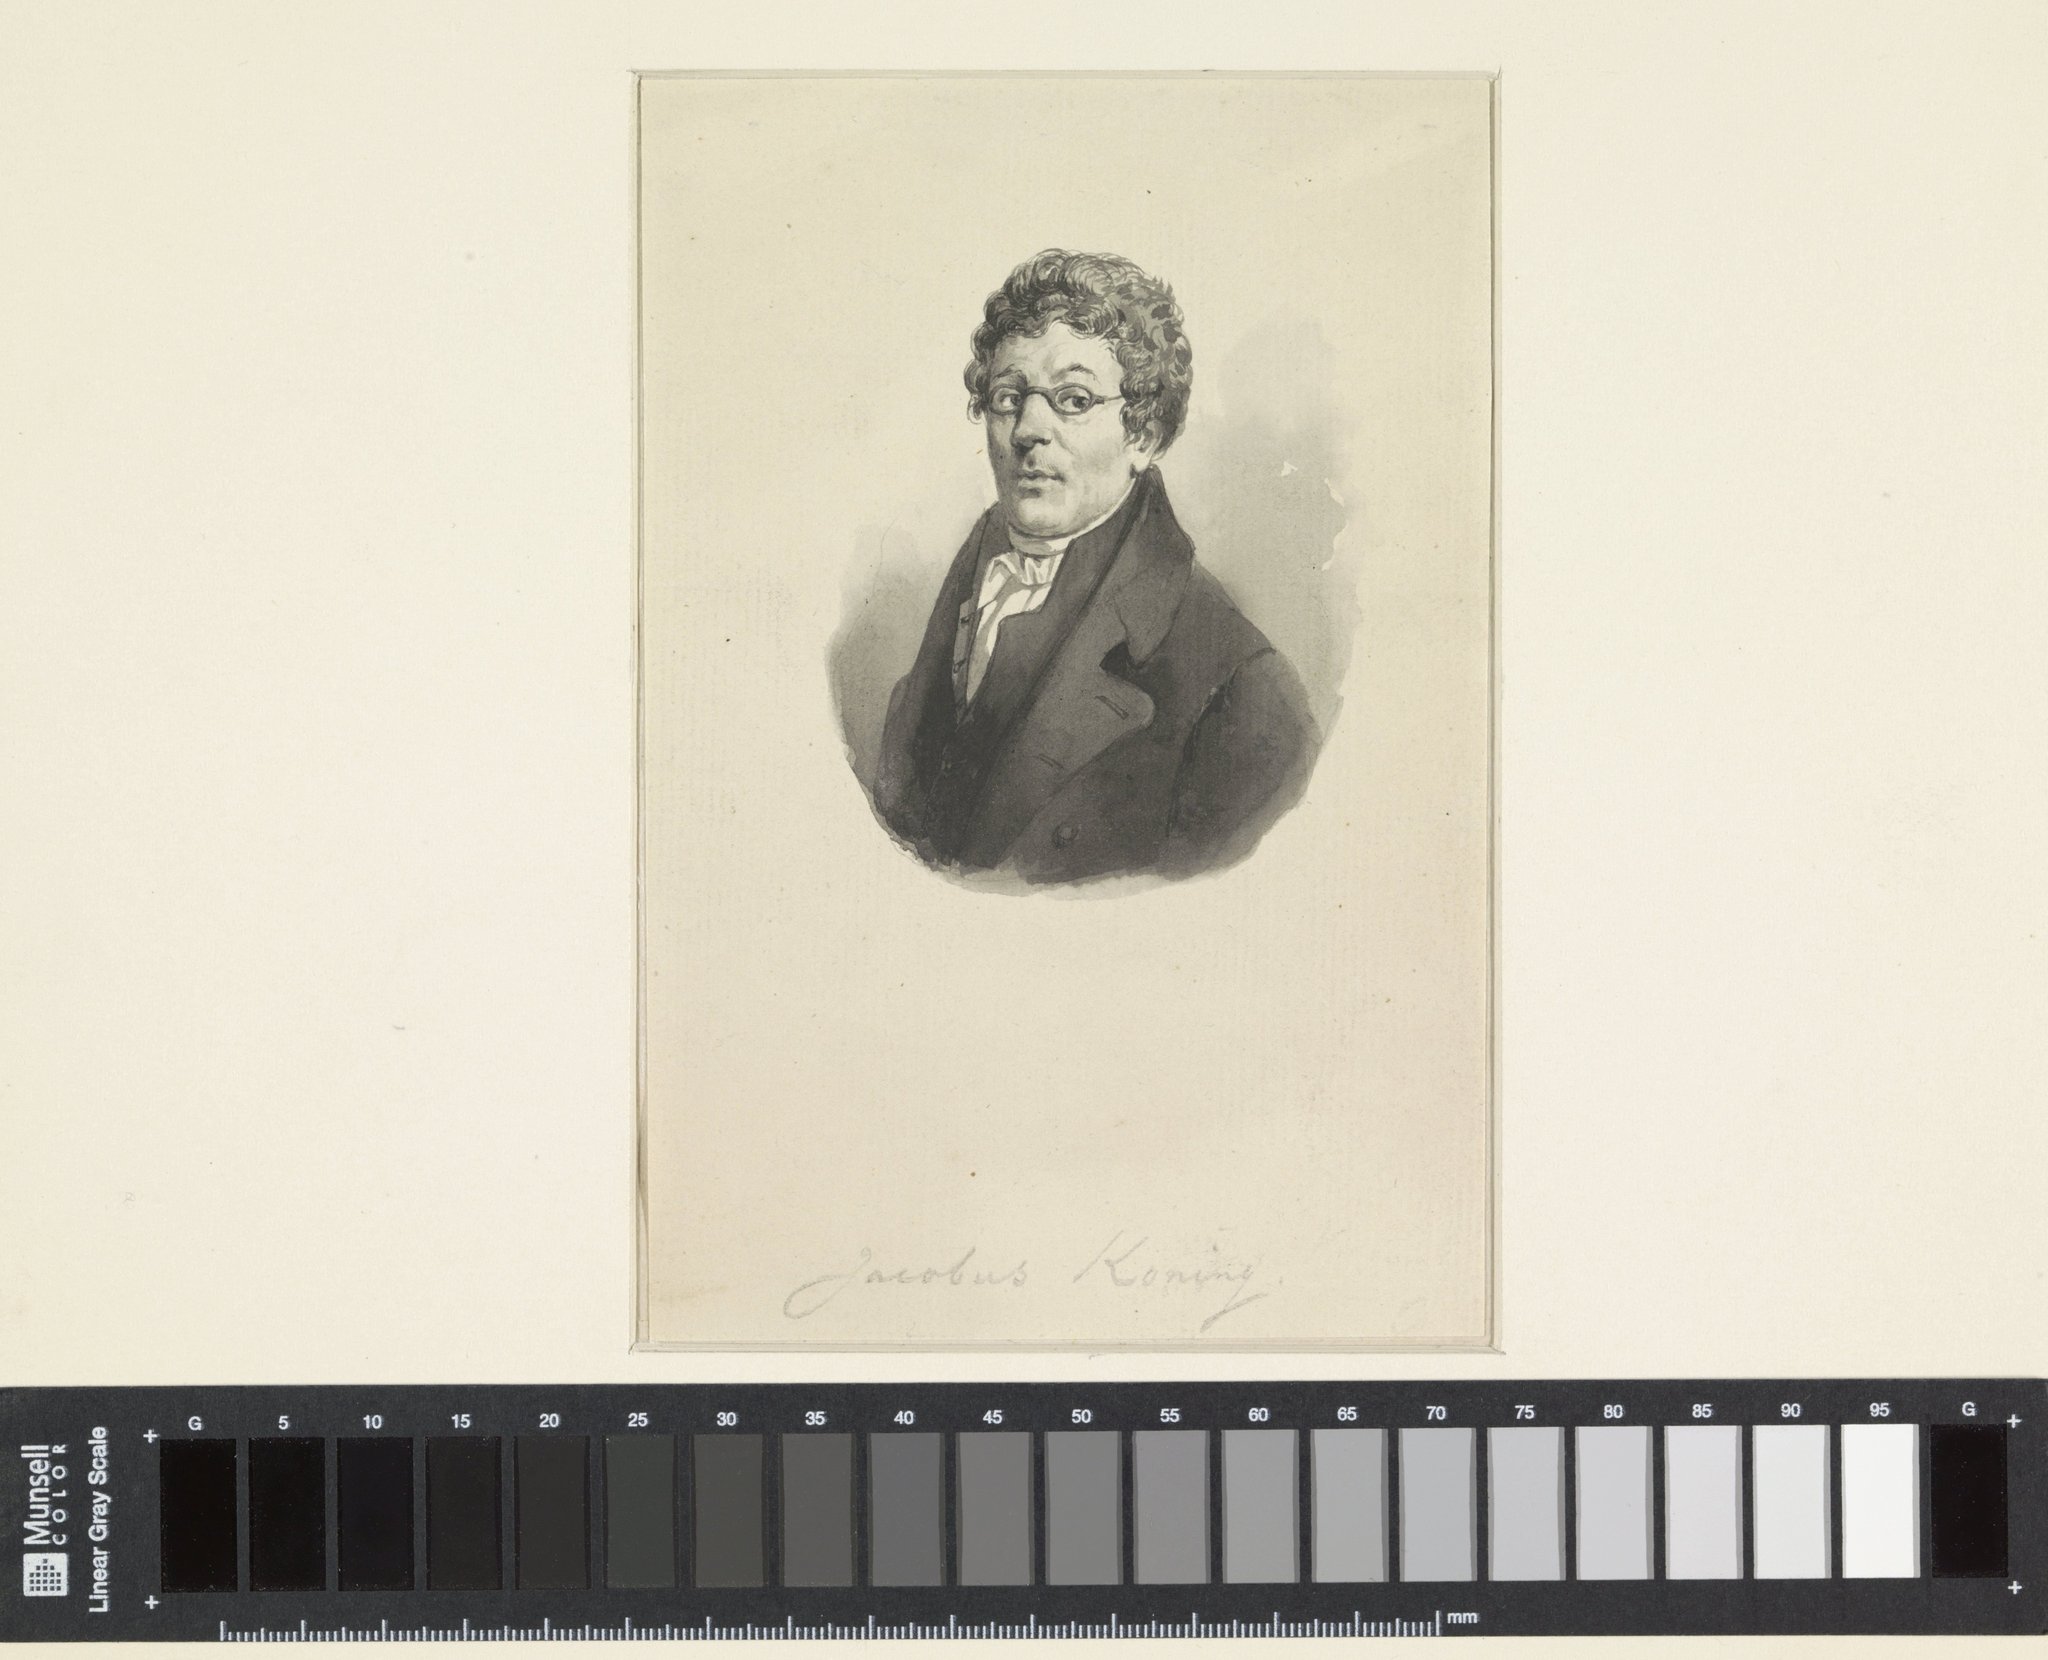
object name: drawing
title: Portret van Jacobus Koning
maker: jean augustin daiwaille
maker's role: draughtsman, print maker, printer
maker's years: 1786-1850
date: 1796-1850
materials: paper, pencil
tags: amsterdam, jacobus koning, historical persons, portrait of a writer, portrait, self-portrait of artist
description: Portret van de schrijver Jacobus Koning (1770-1832).